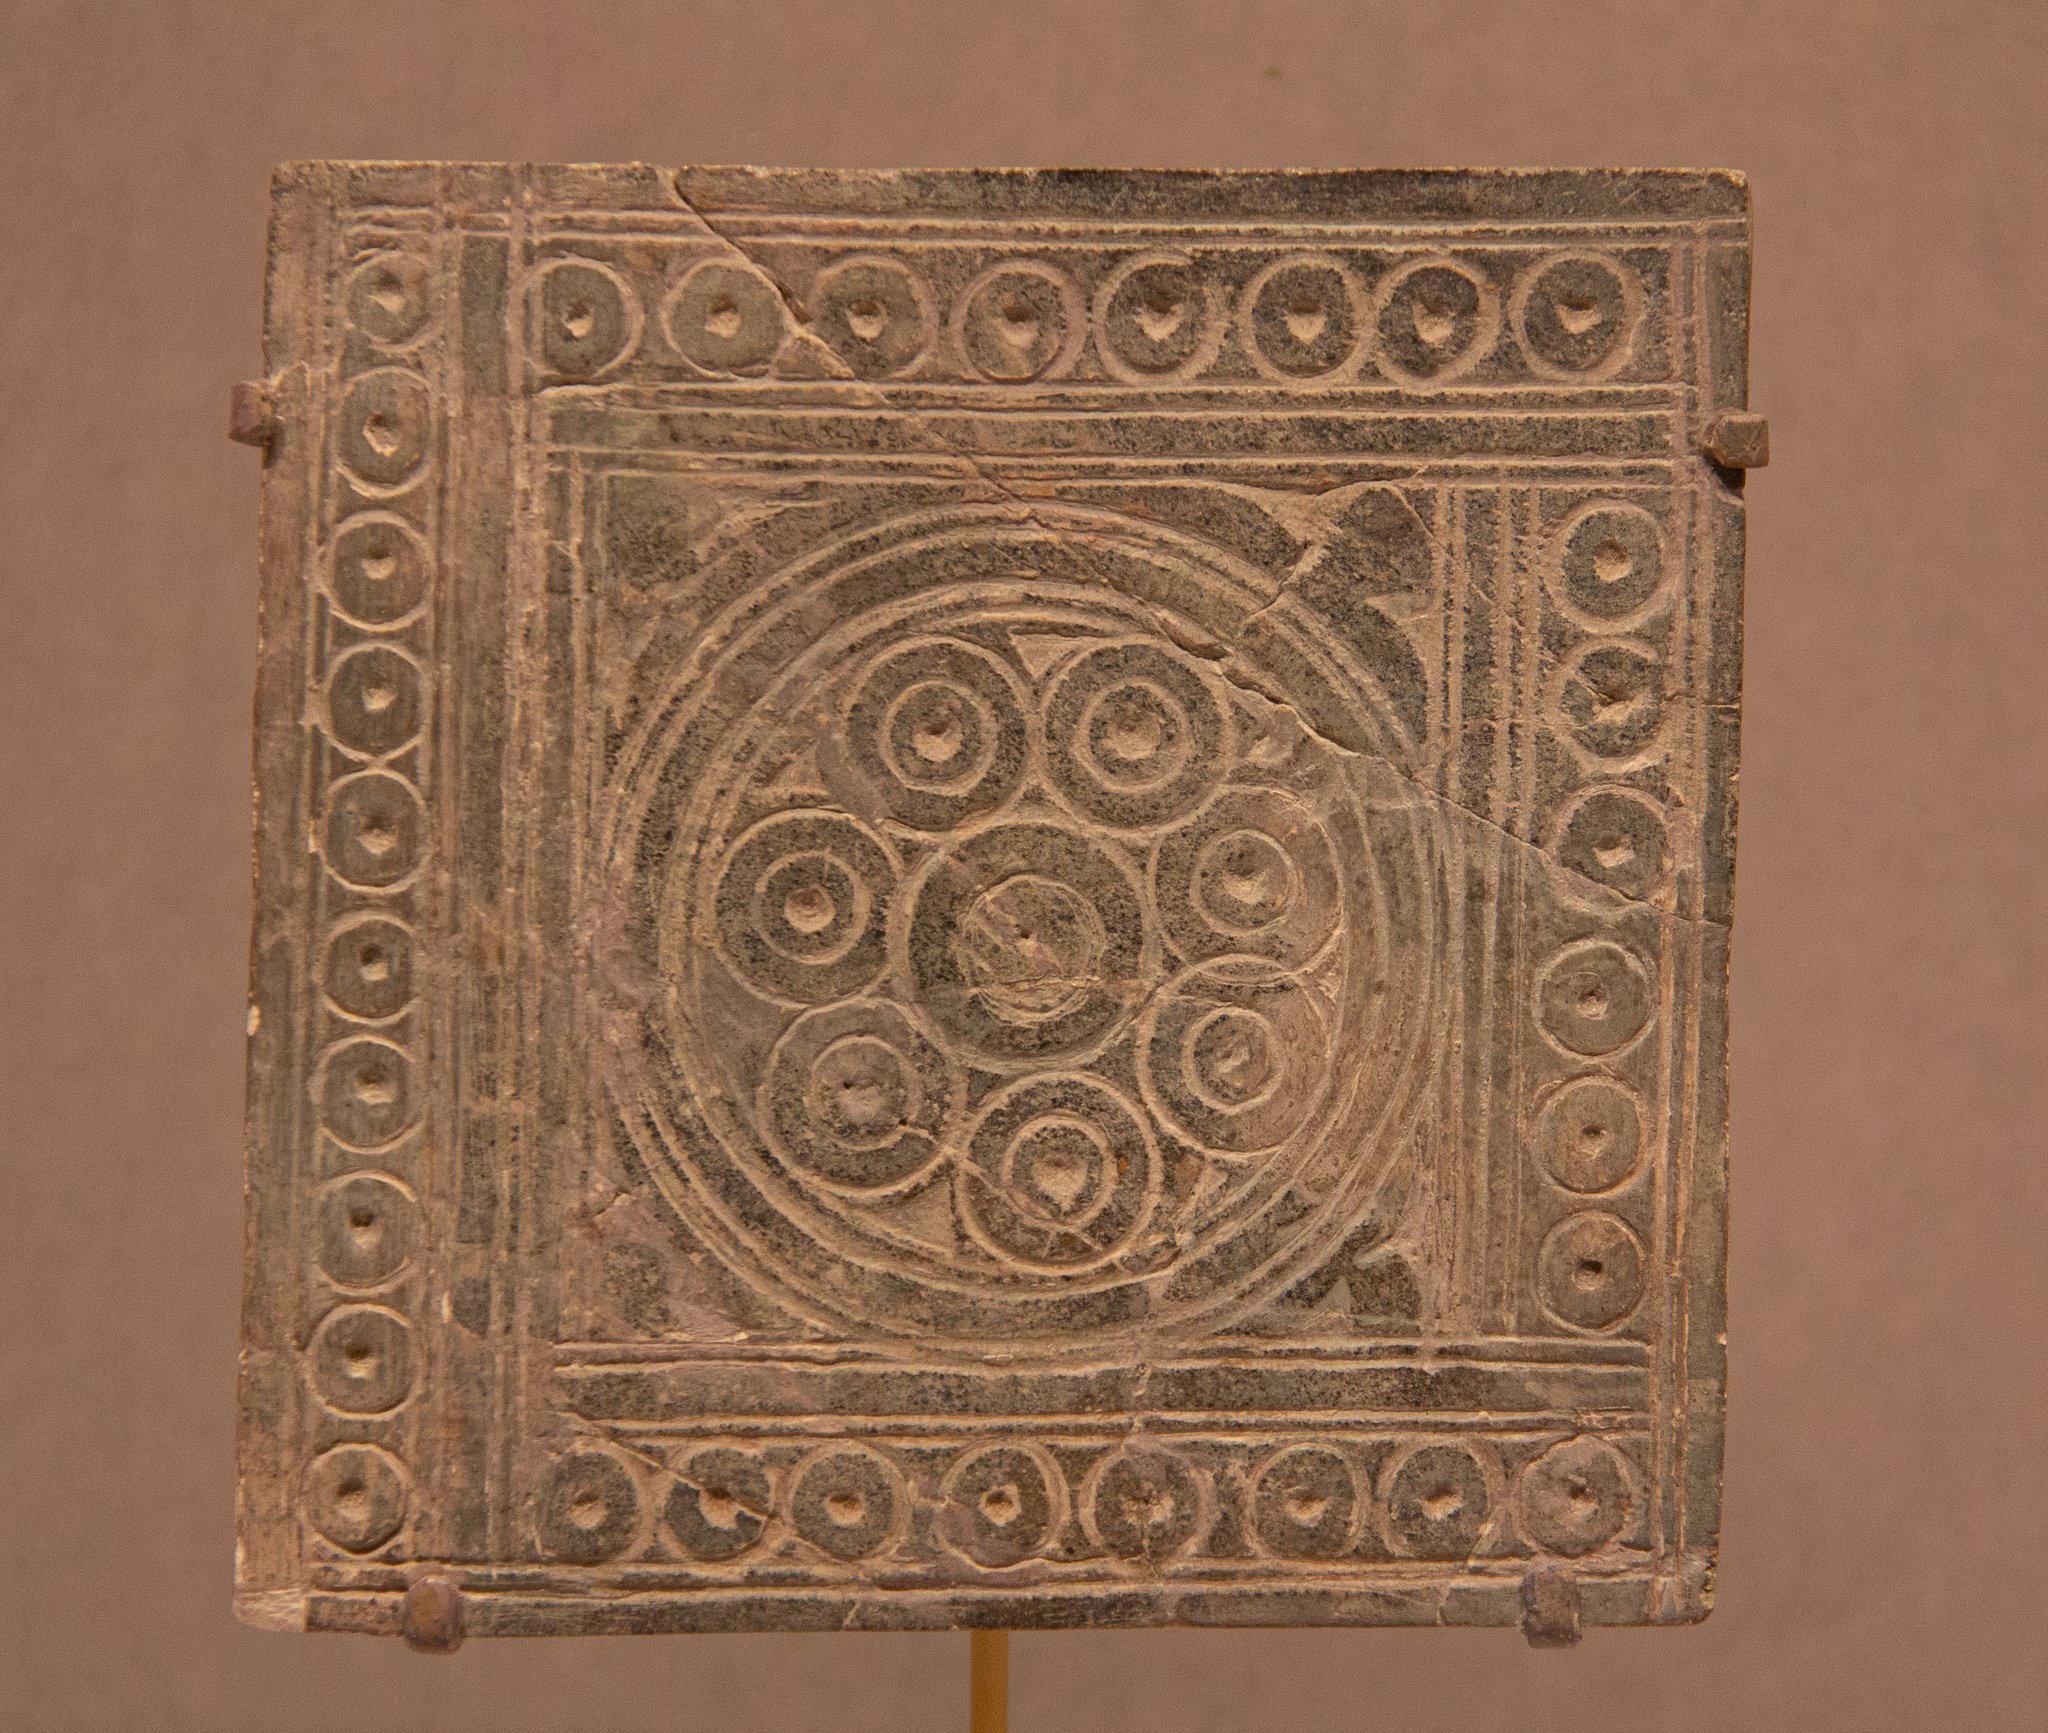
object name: panel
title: Panel from a Box (?)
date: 801-1100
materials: stone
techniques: carving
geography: iran